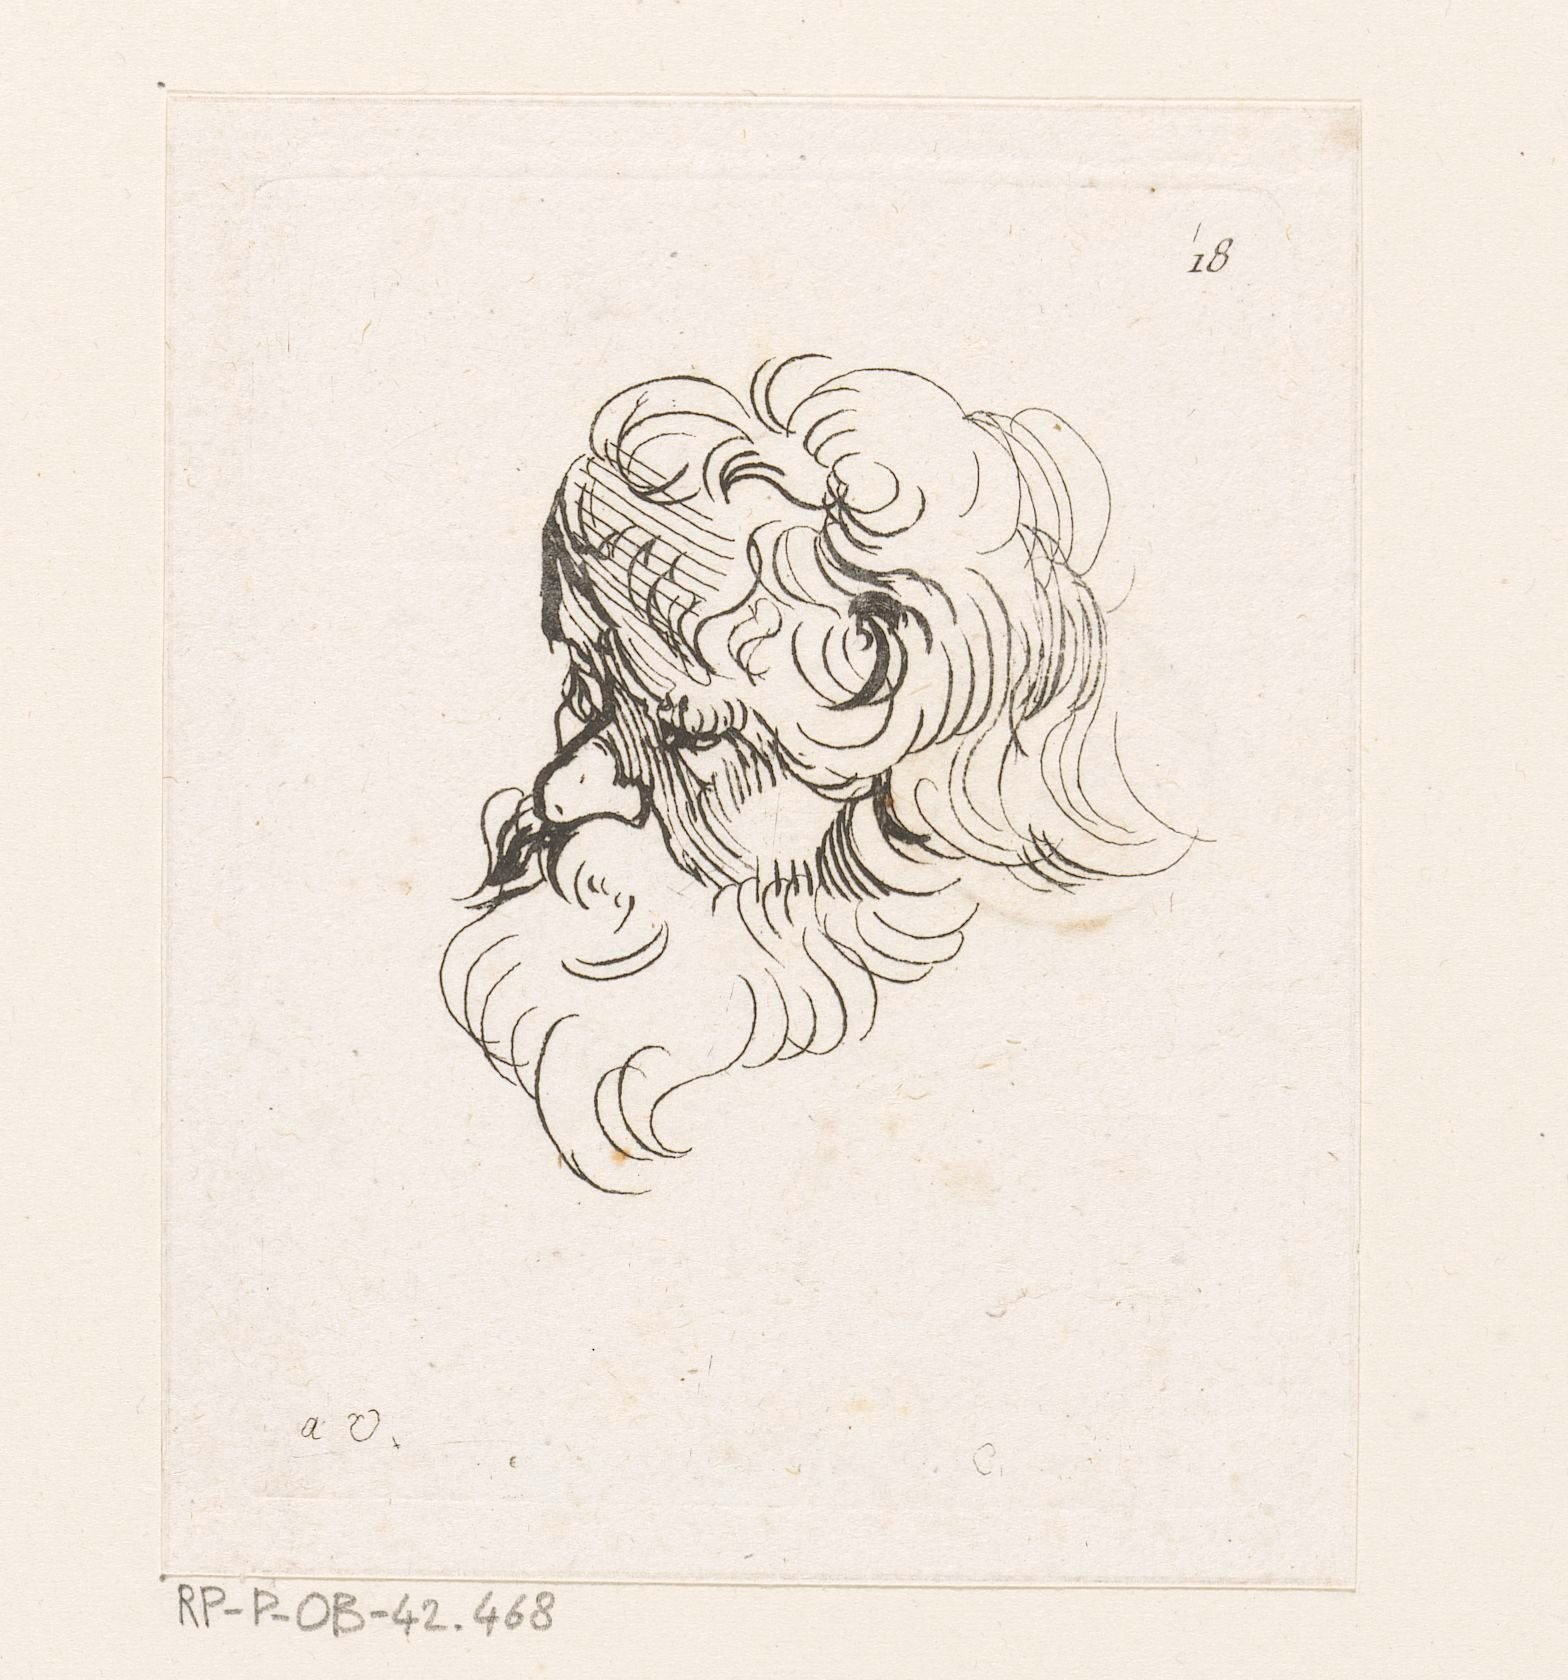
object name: print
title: Hoofd van een man met baard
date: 1735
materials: paper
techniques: etching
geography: france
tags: head (human), adult man, beard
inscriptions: collector's mark: Lugt 240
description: Prent uit een serie van 31 prenten naar getekende hoofden door Van Dyck, plus een titelprent naar Bouchardon, getiteld: "Recueil de Testes d'Antoine Van Dyck tirées du Cabinet de M. Crozat et gravées par M. le C. de C.".